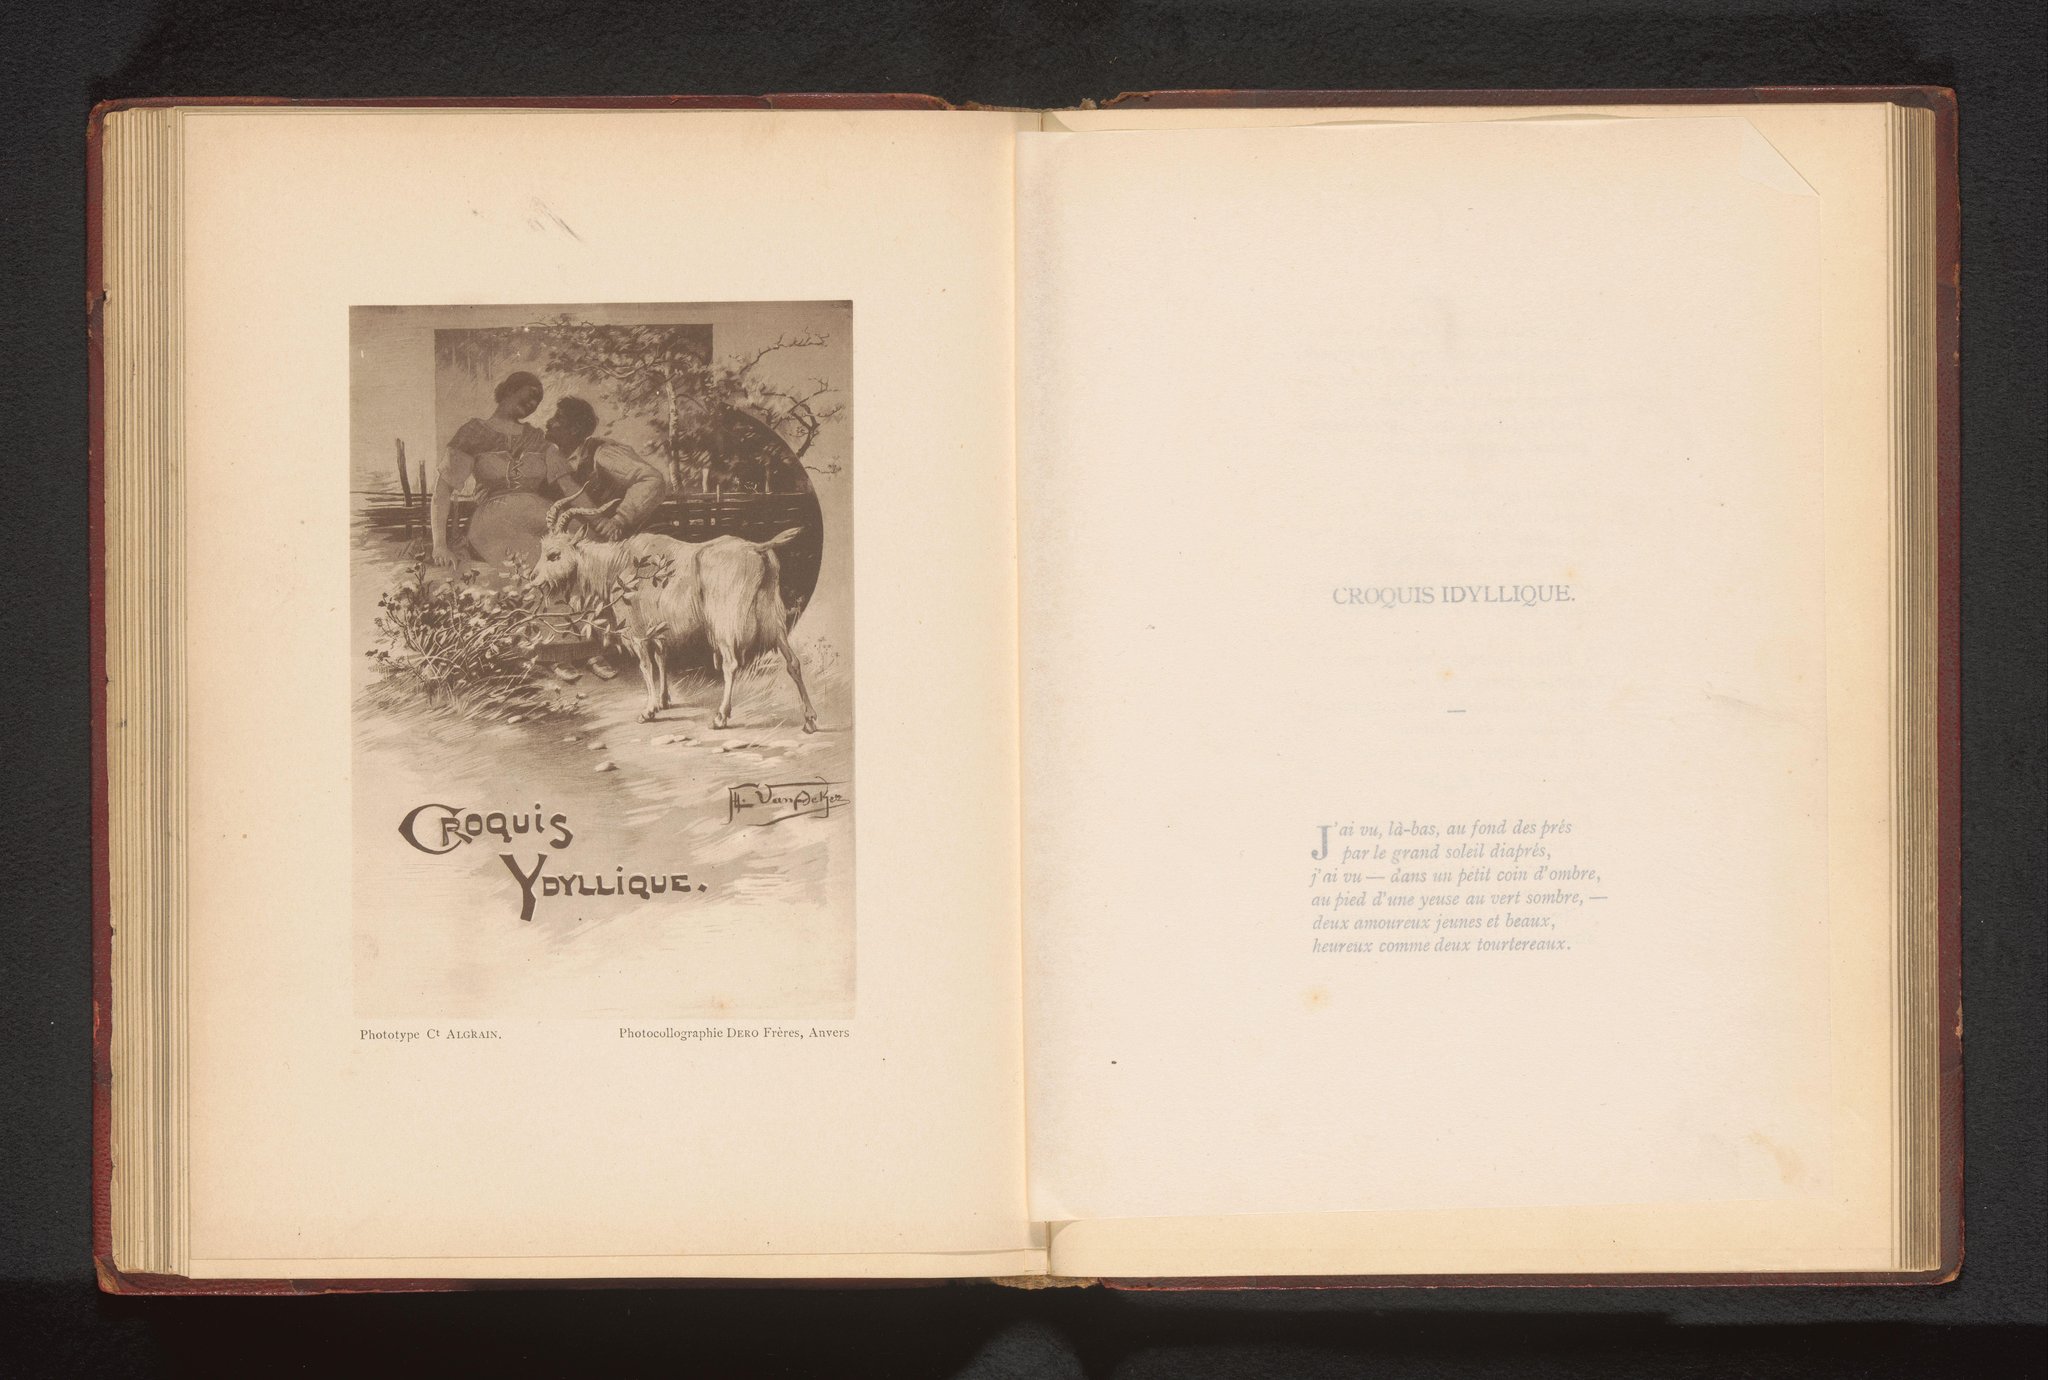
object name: page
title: Croquis Ydyllique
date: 1888-1893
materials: paper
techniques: photograph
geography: antwerp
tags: trees, adult woman, adult man, goat